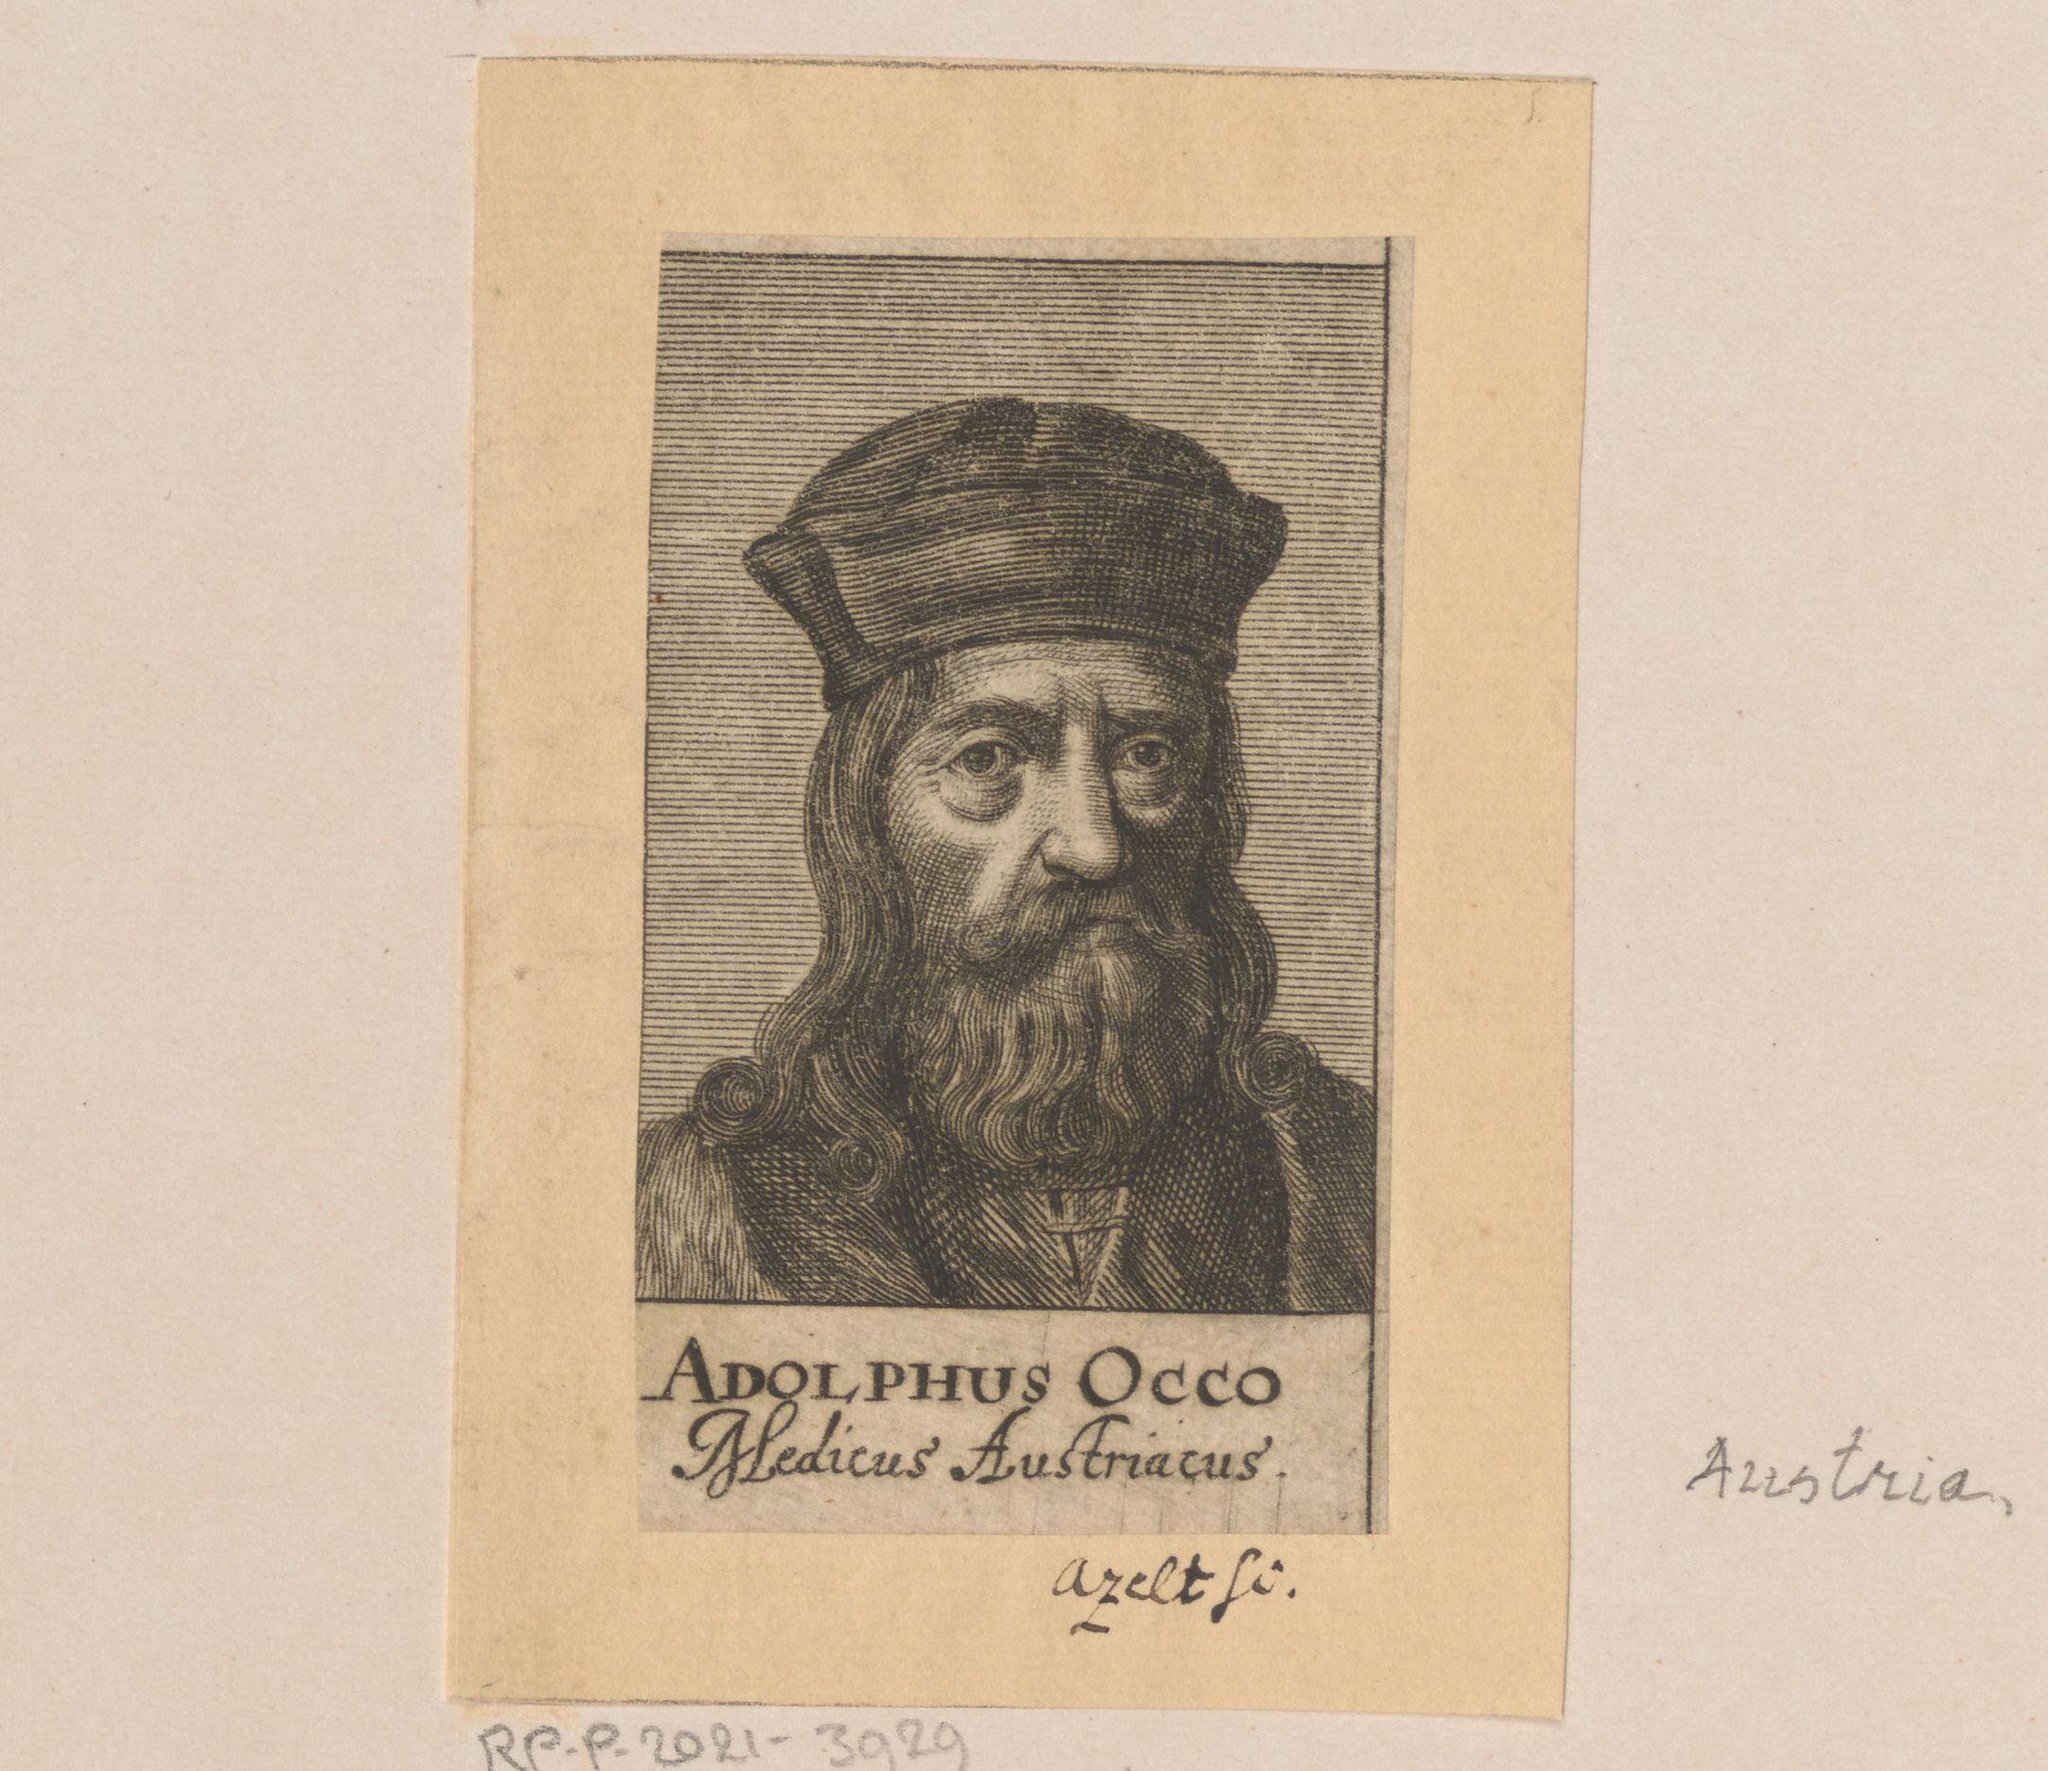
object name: print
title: Portret van Adolph Occo II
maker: Anonymous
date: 1688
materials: paper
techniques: engraving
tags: augsburg, historical persons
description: Prent mogelijk uit: Freher, Paul. Theatrum virorum eruditione clarorum. Neurenberg: Johann Hoffmann, 1688.